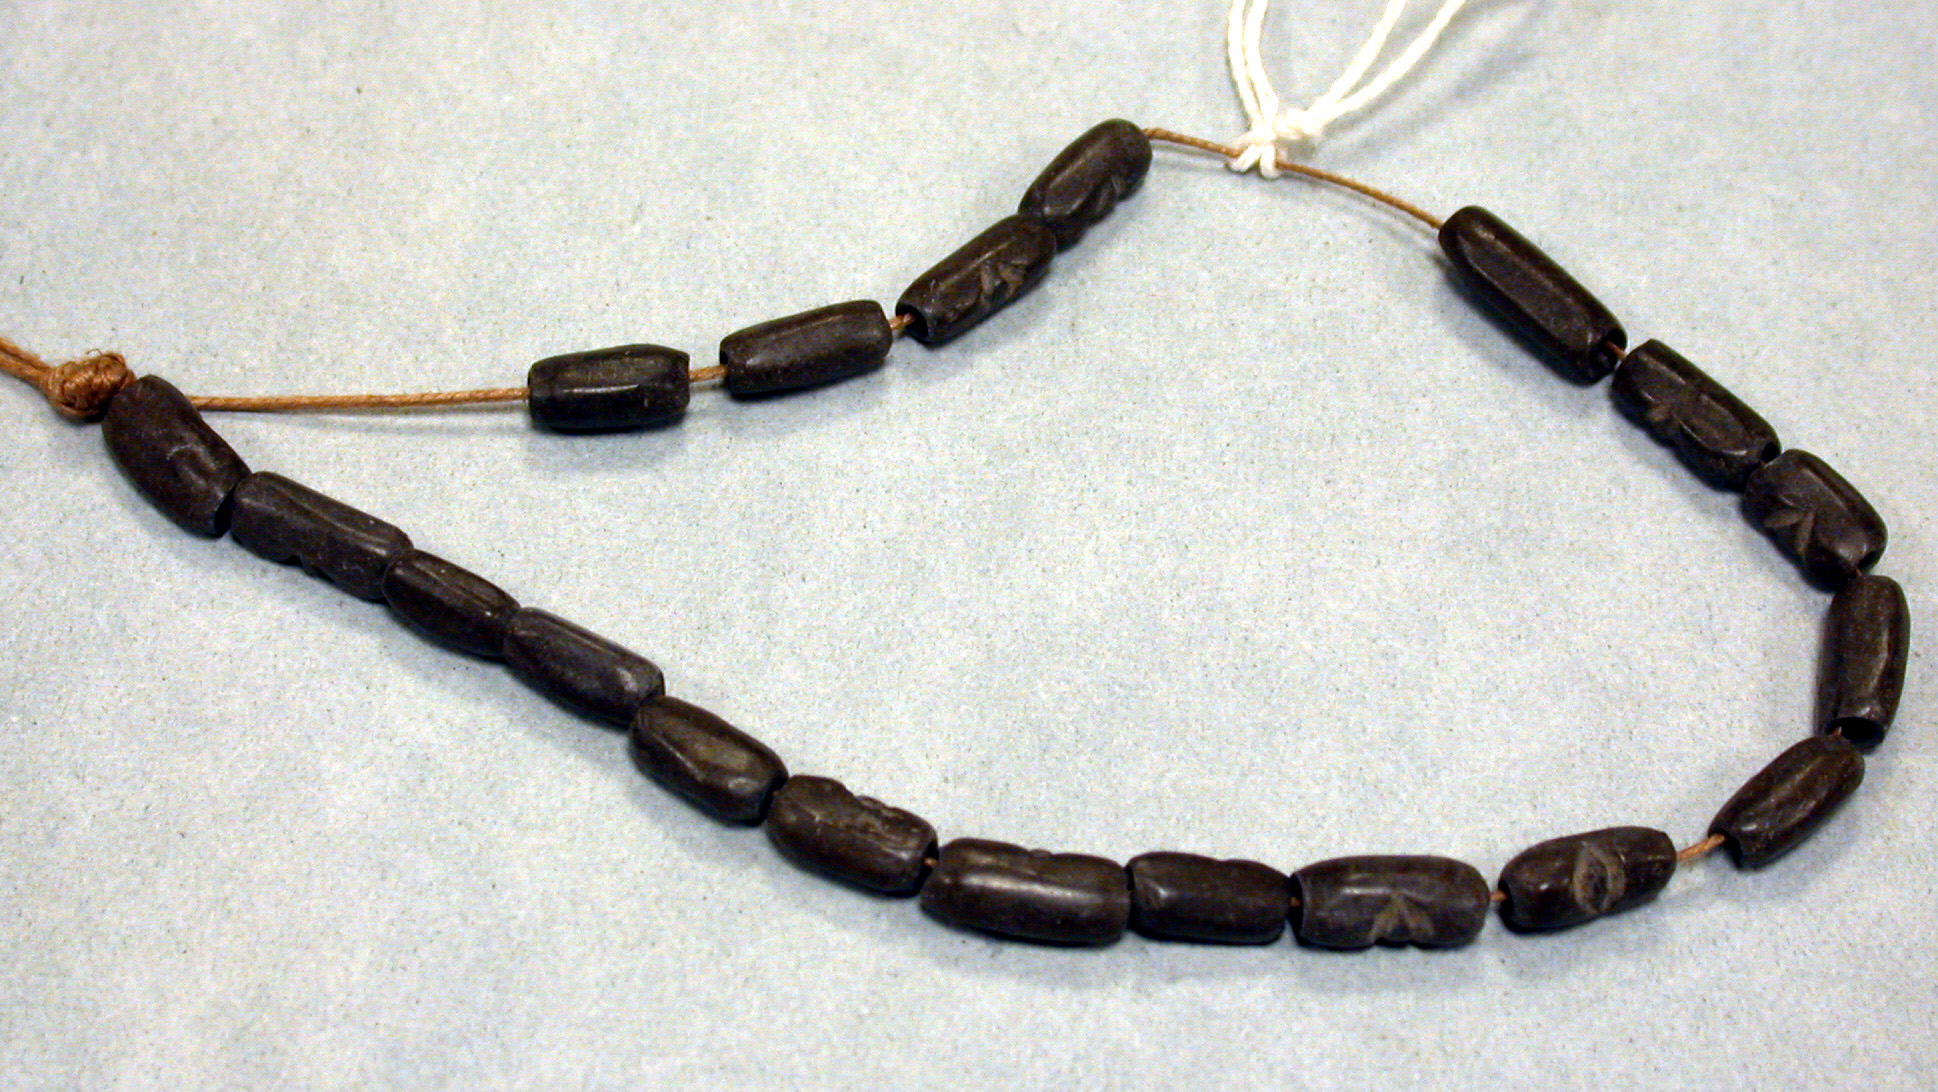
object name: bead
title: Necklace of Stone Beads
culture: peruvian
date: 1-1566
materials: stone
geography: peru